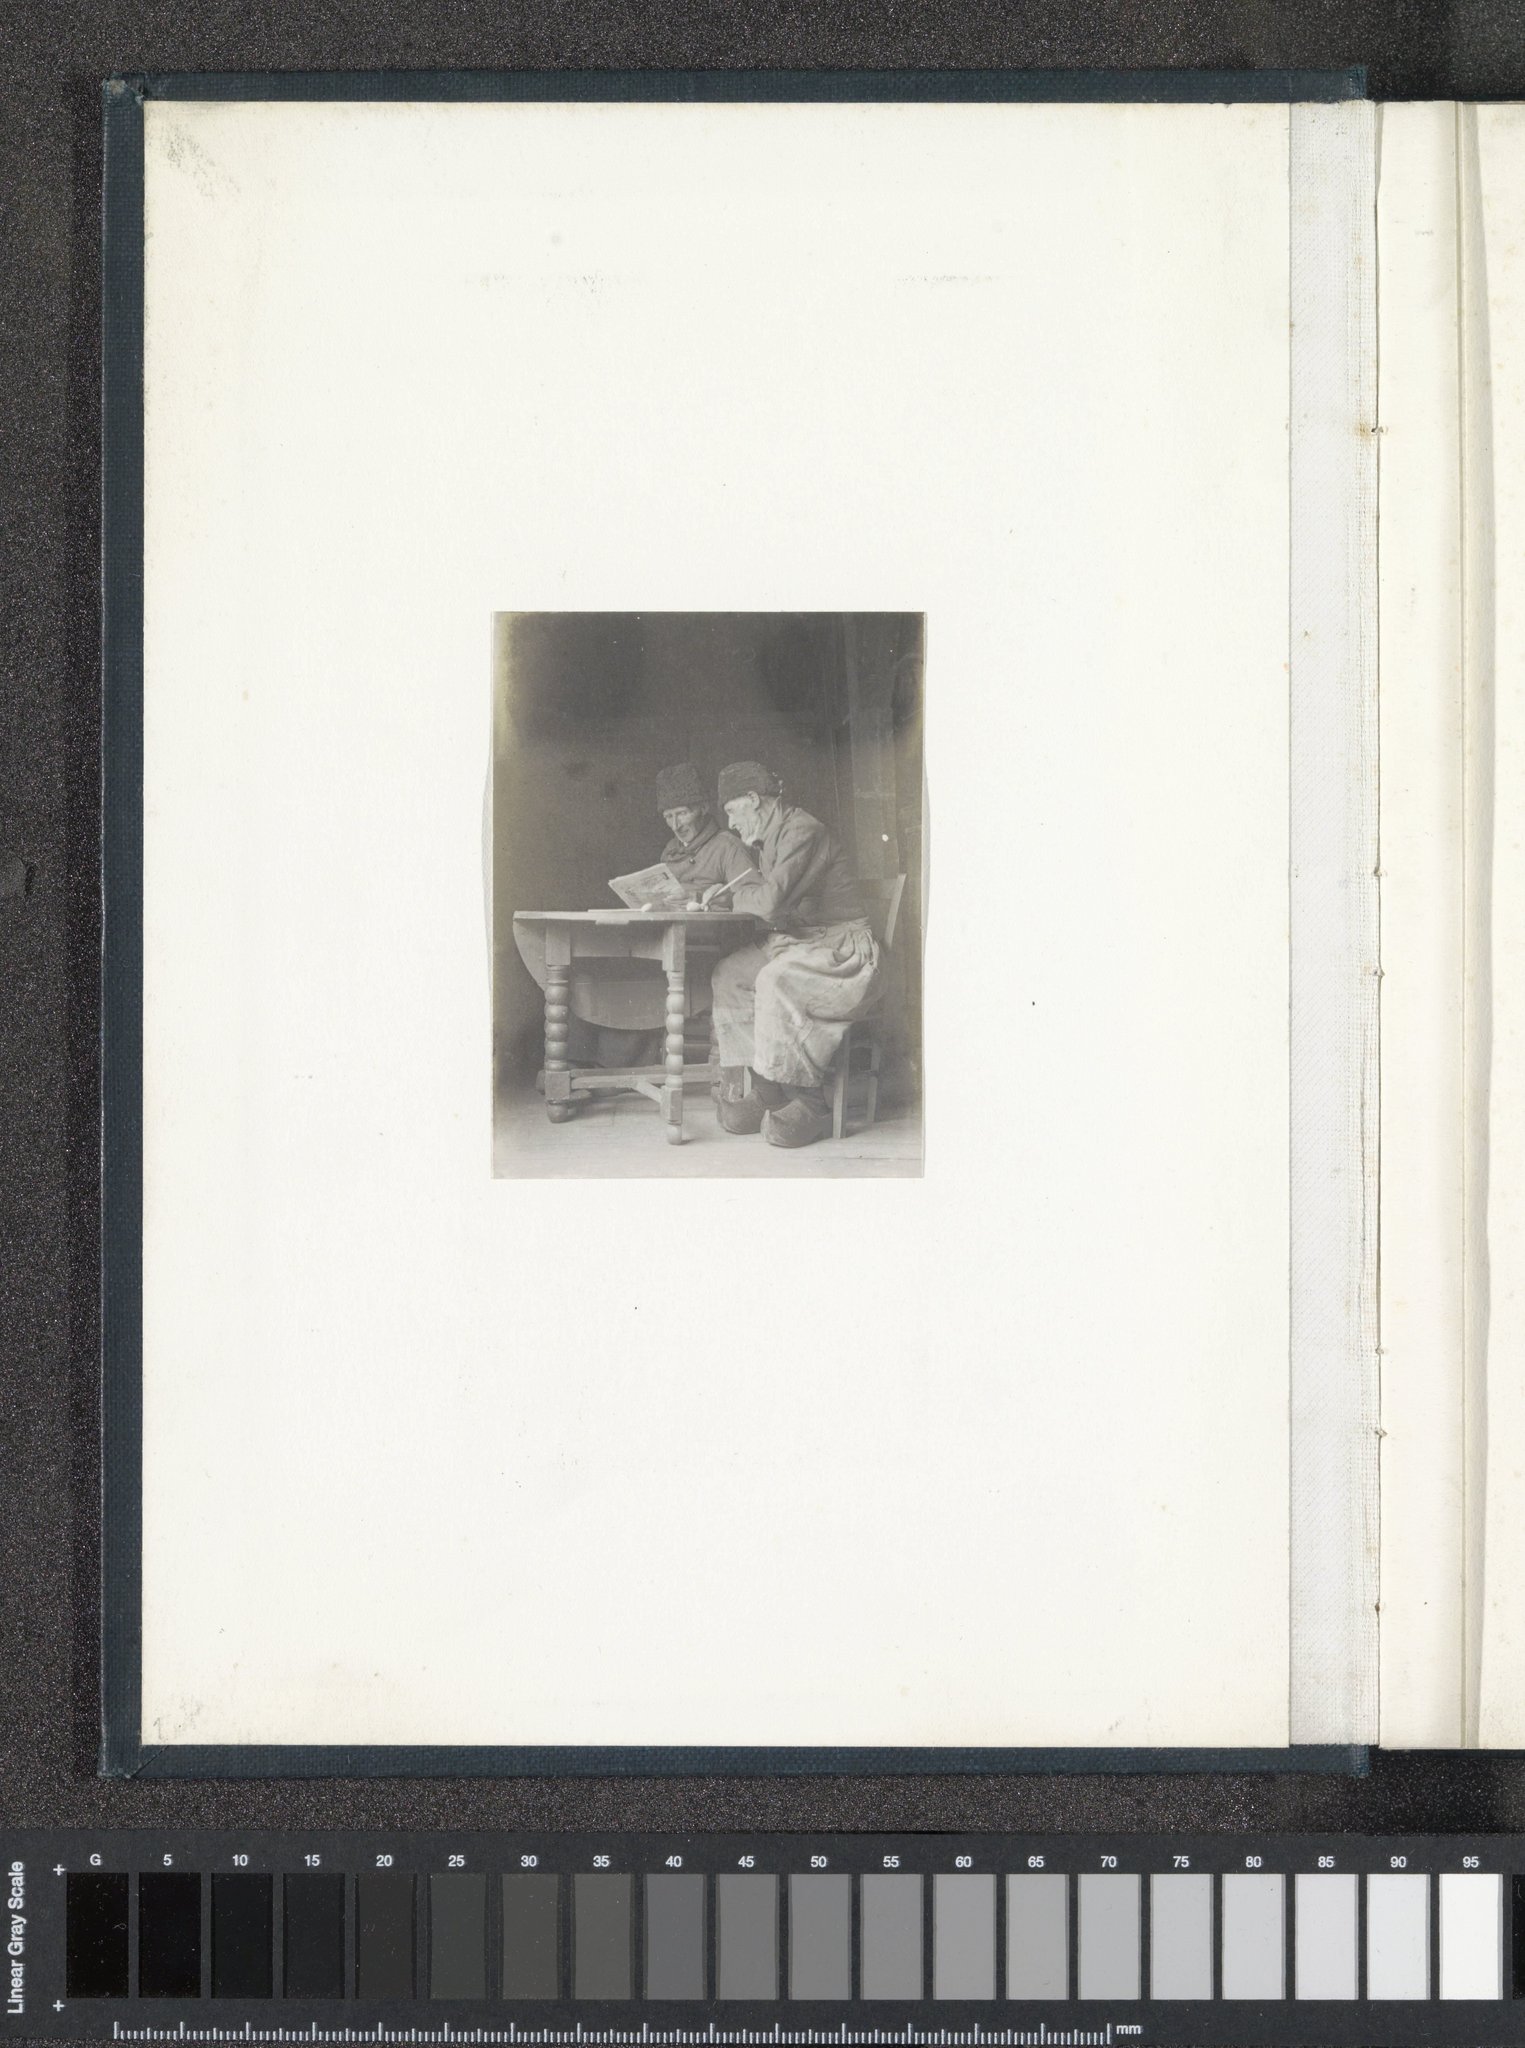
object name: photograph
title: Portret van twee mannen in Volendamse klederdracht, zittend aan een tafel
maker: george hidderley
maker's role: fotograaf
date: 1900-1910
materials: paper, photographic support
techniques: gelatin silver print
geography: volendam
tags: sitting figure, folk costume, regional costume (+ men's clothes), pipe ~ tobacco, reading to somebody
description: Onderdeel van Fotoalbum met opnames van Volendam, Dordrecht, Gorinchem en Woudrichem.